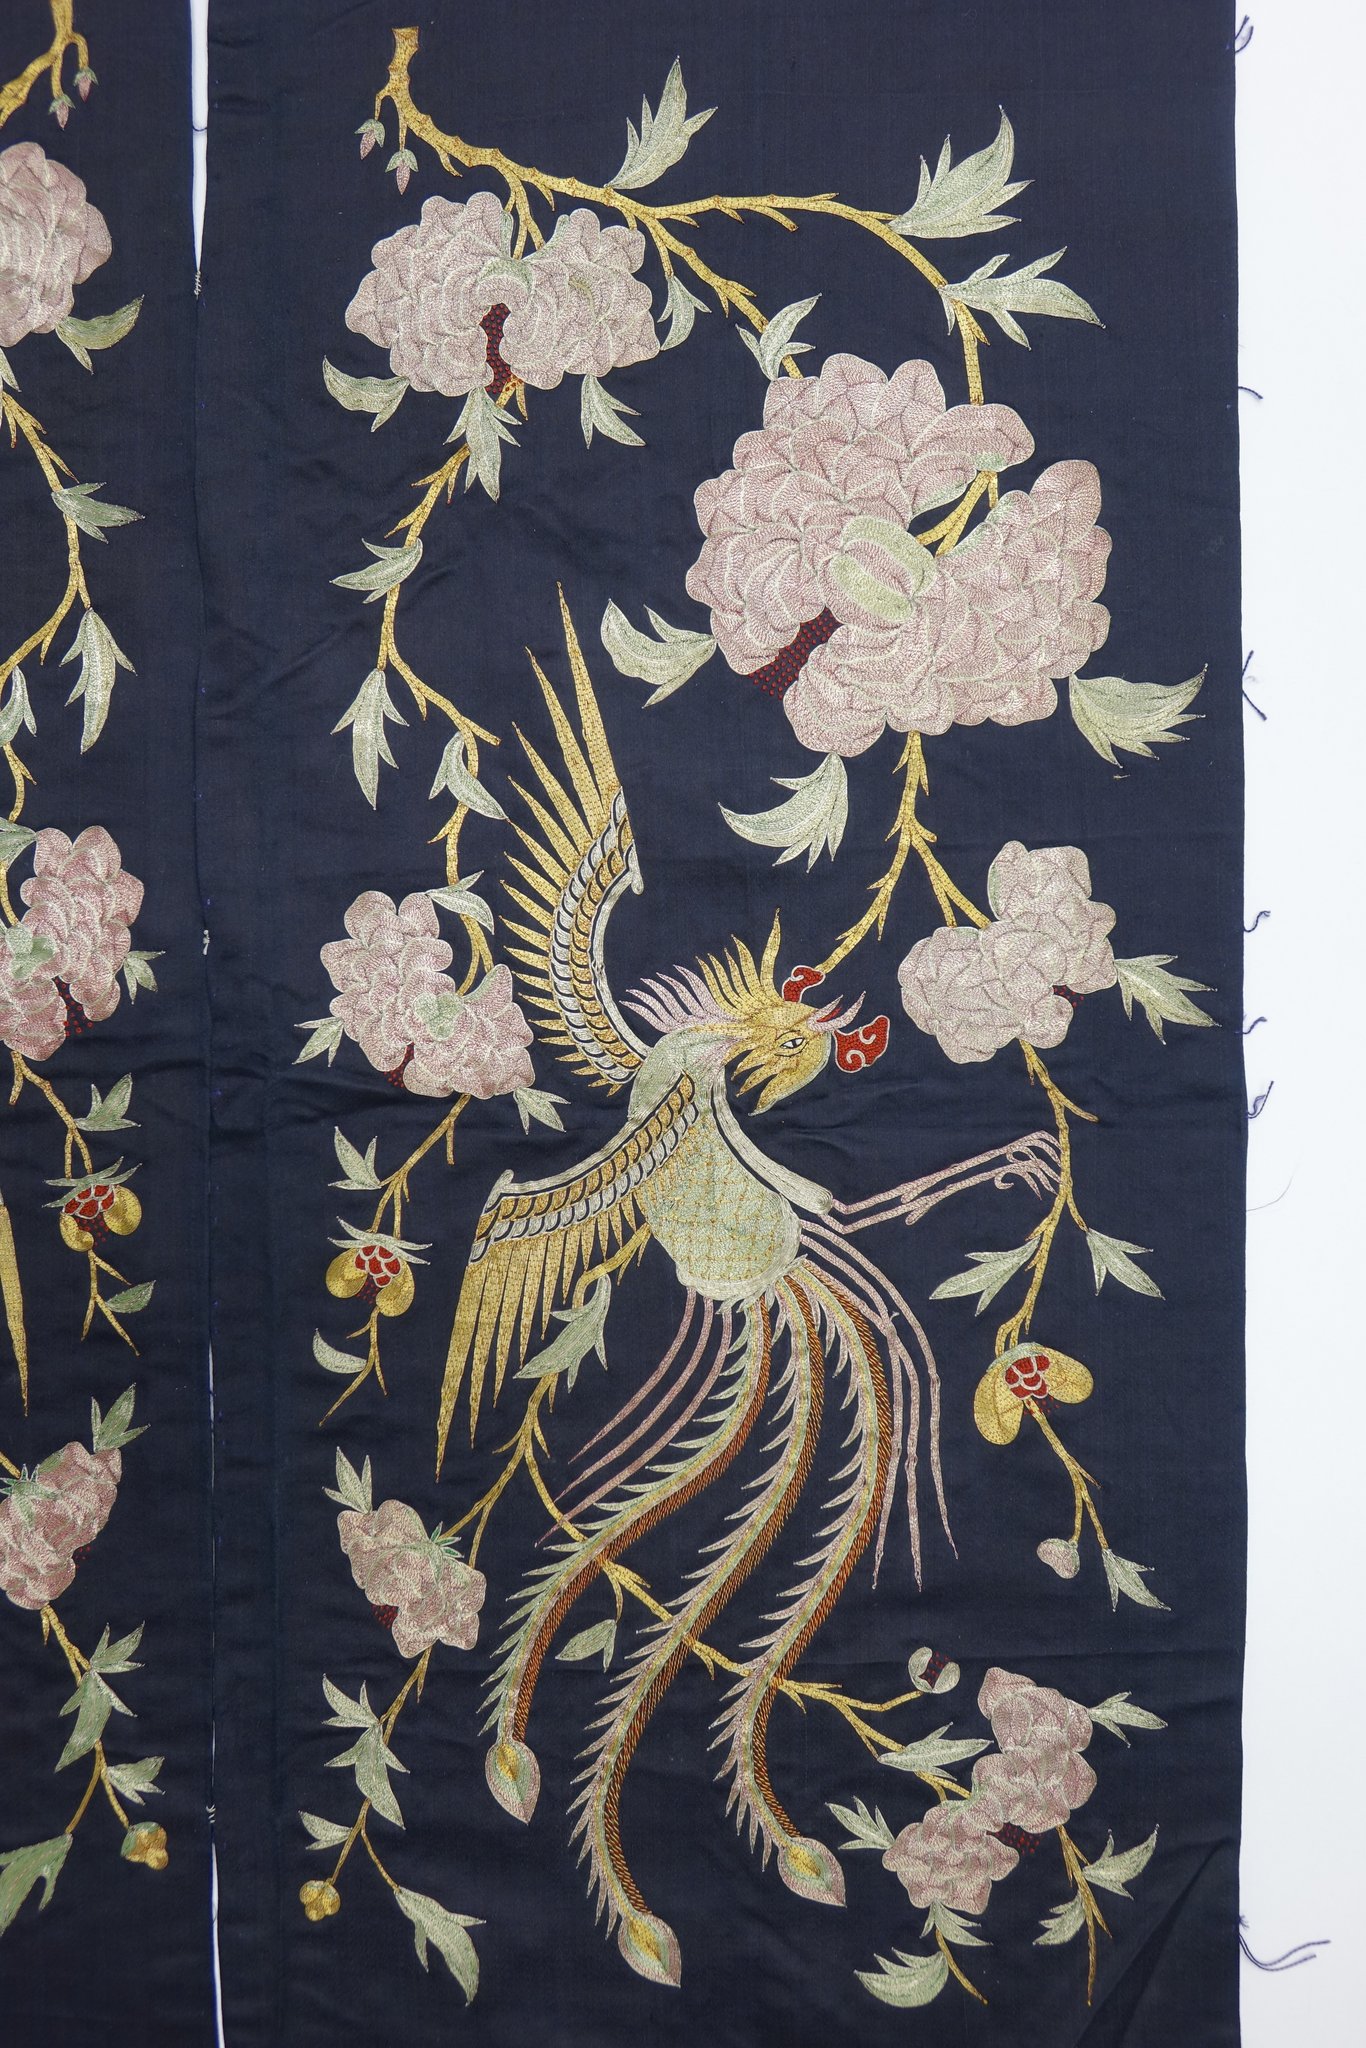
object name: sleeve band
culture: chinese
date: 1801-1900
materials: metal thread, silk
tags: flowers